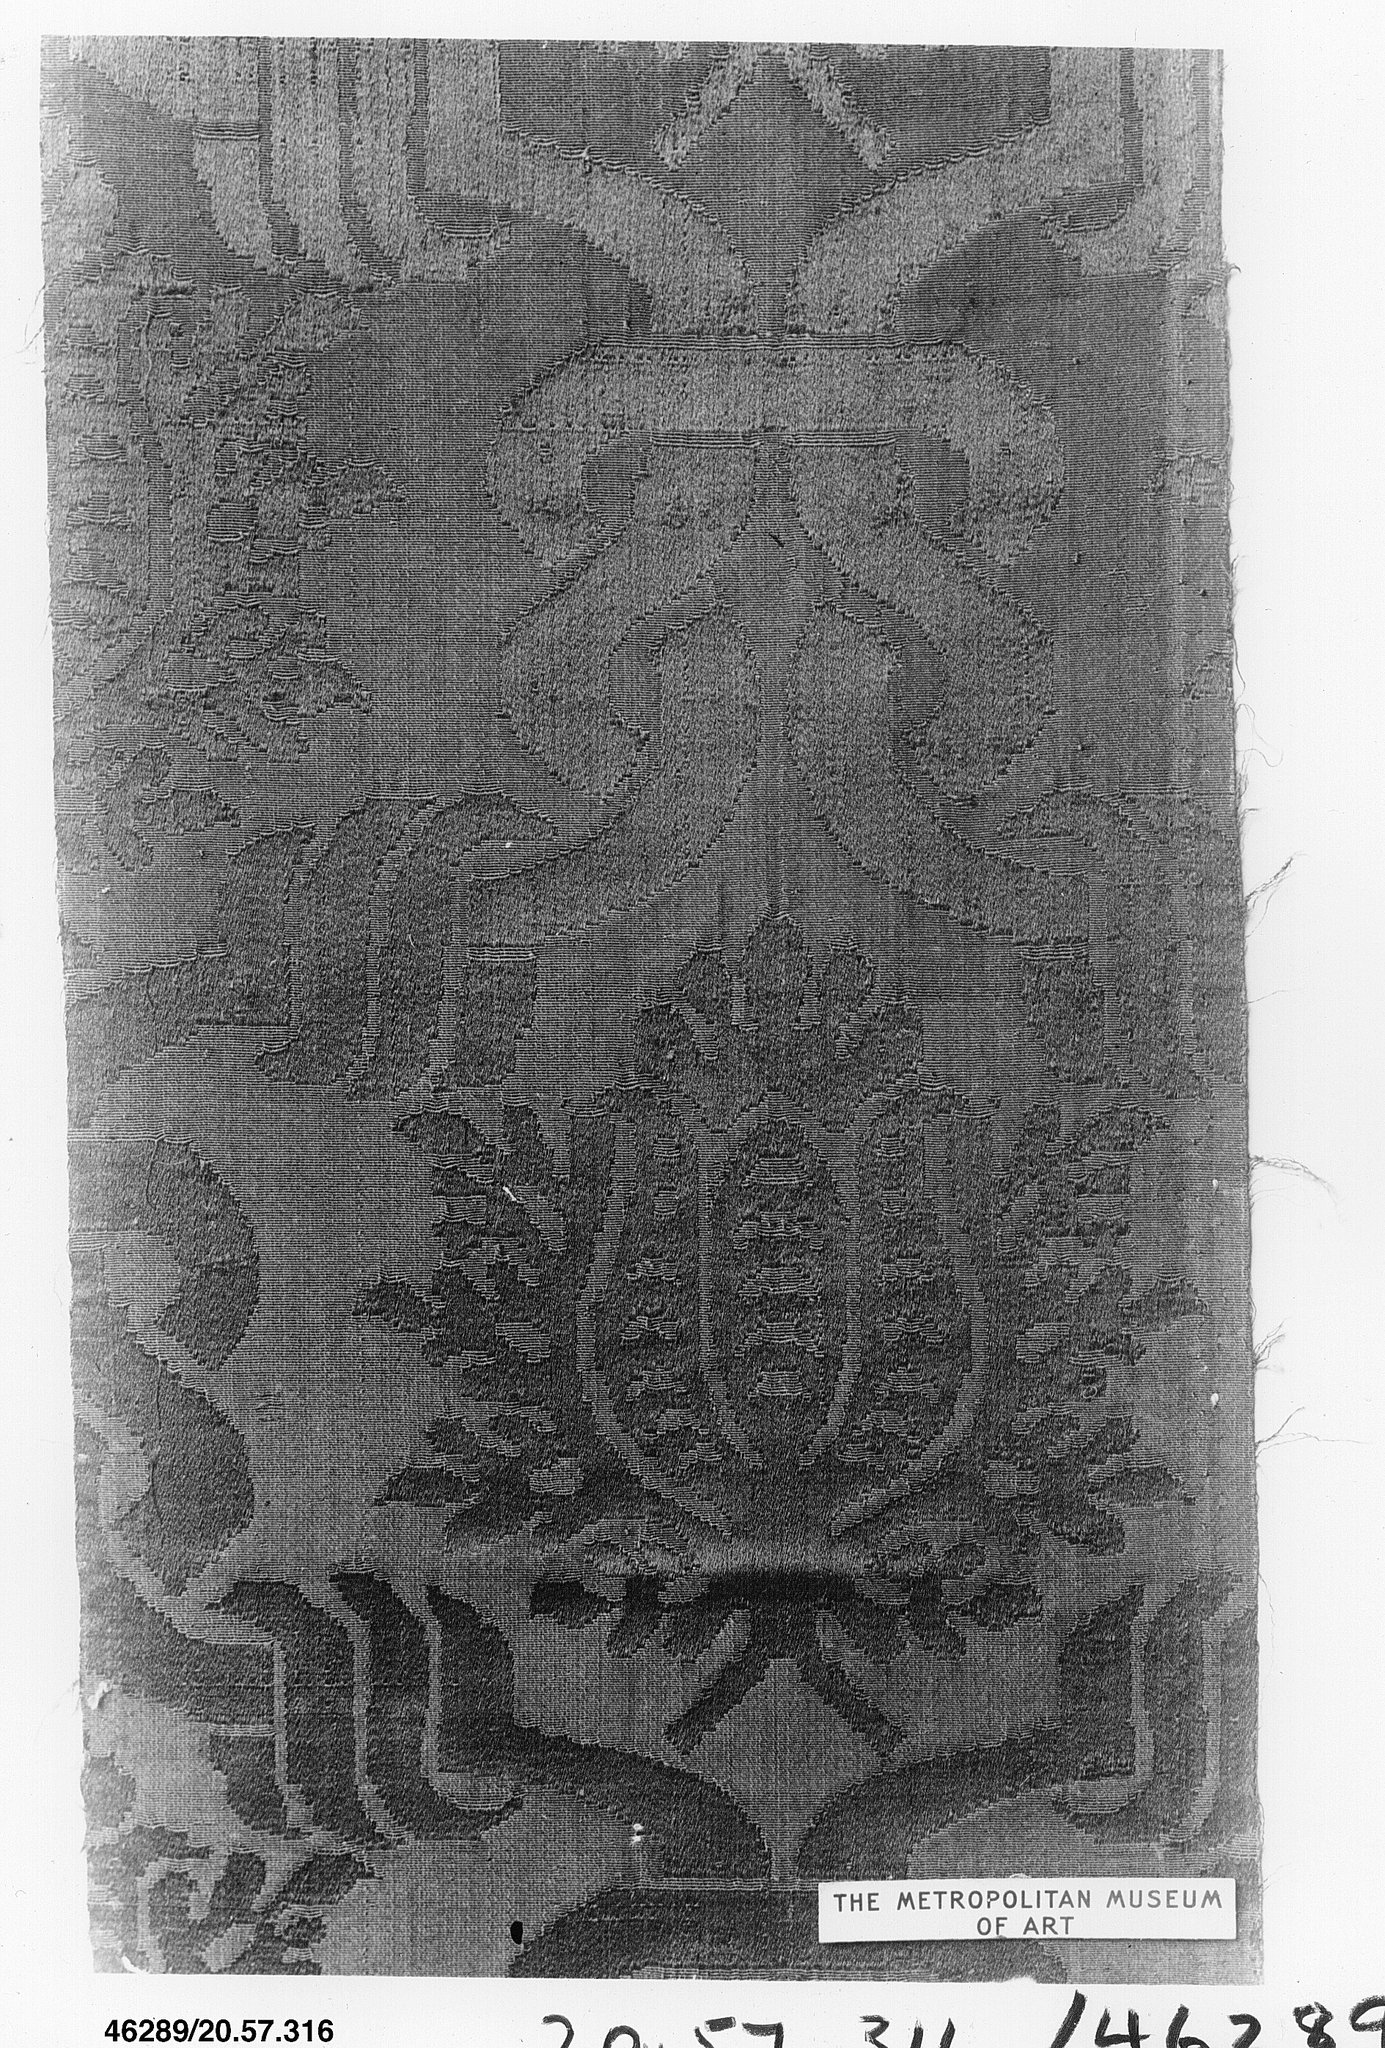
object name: piece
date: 1501-1600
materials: silk